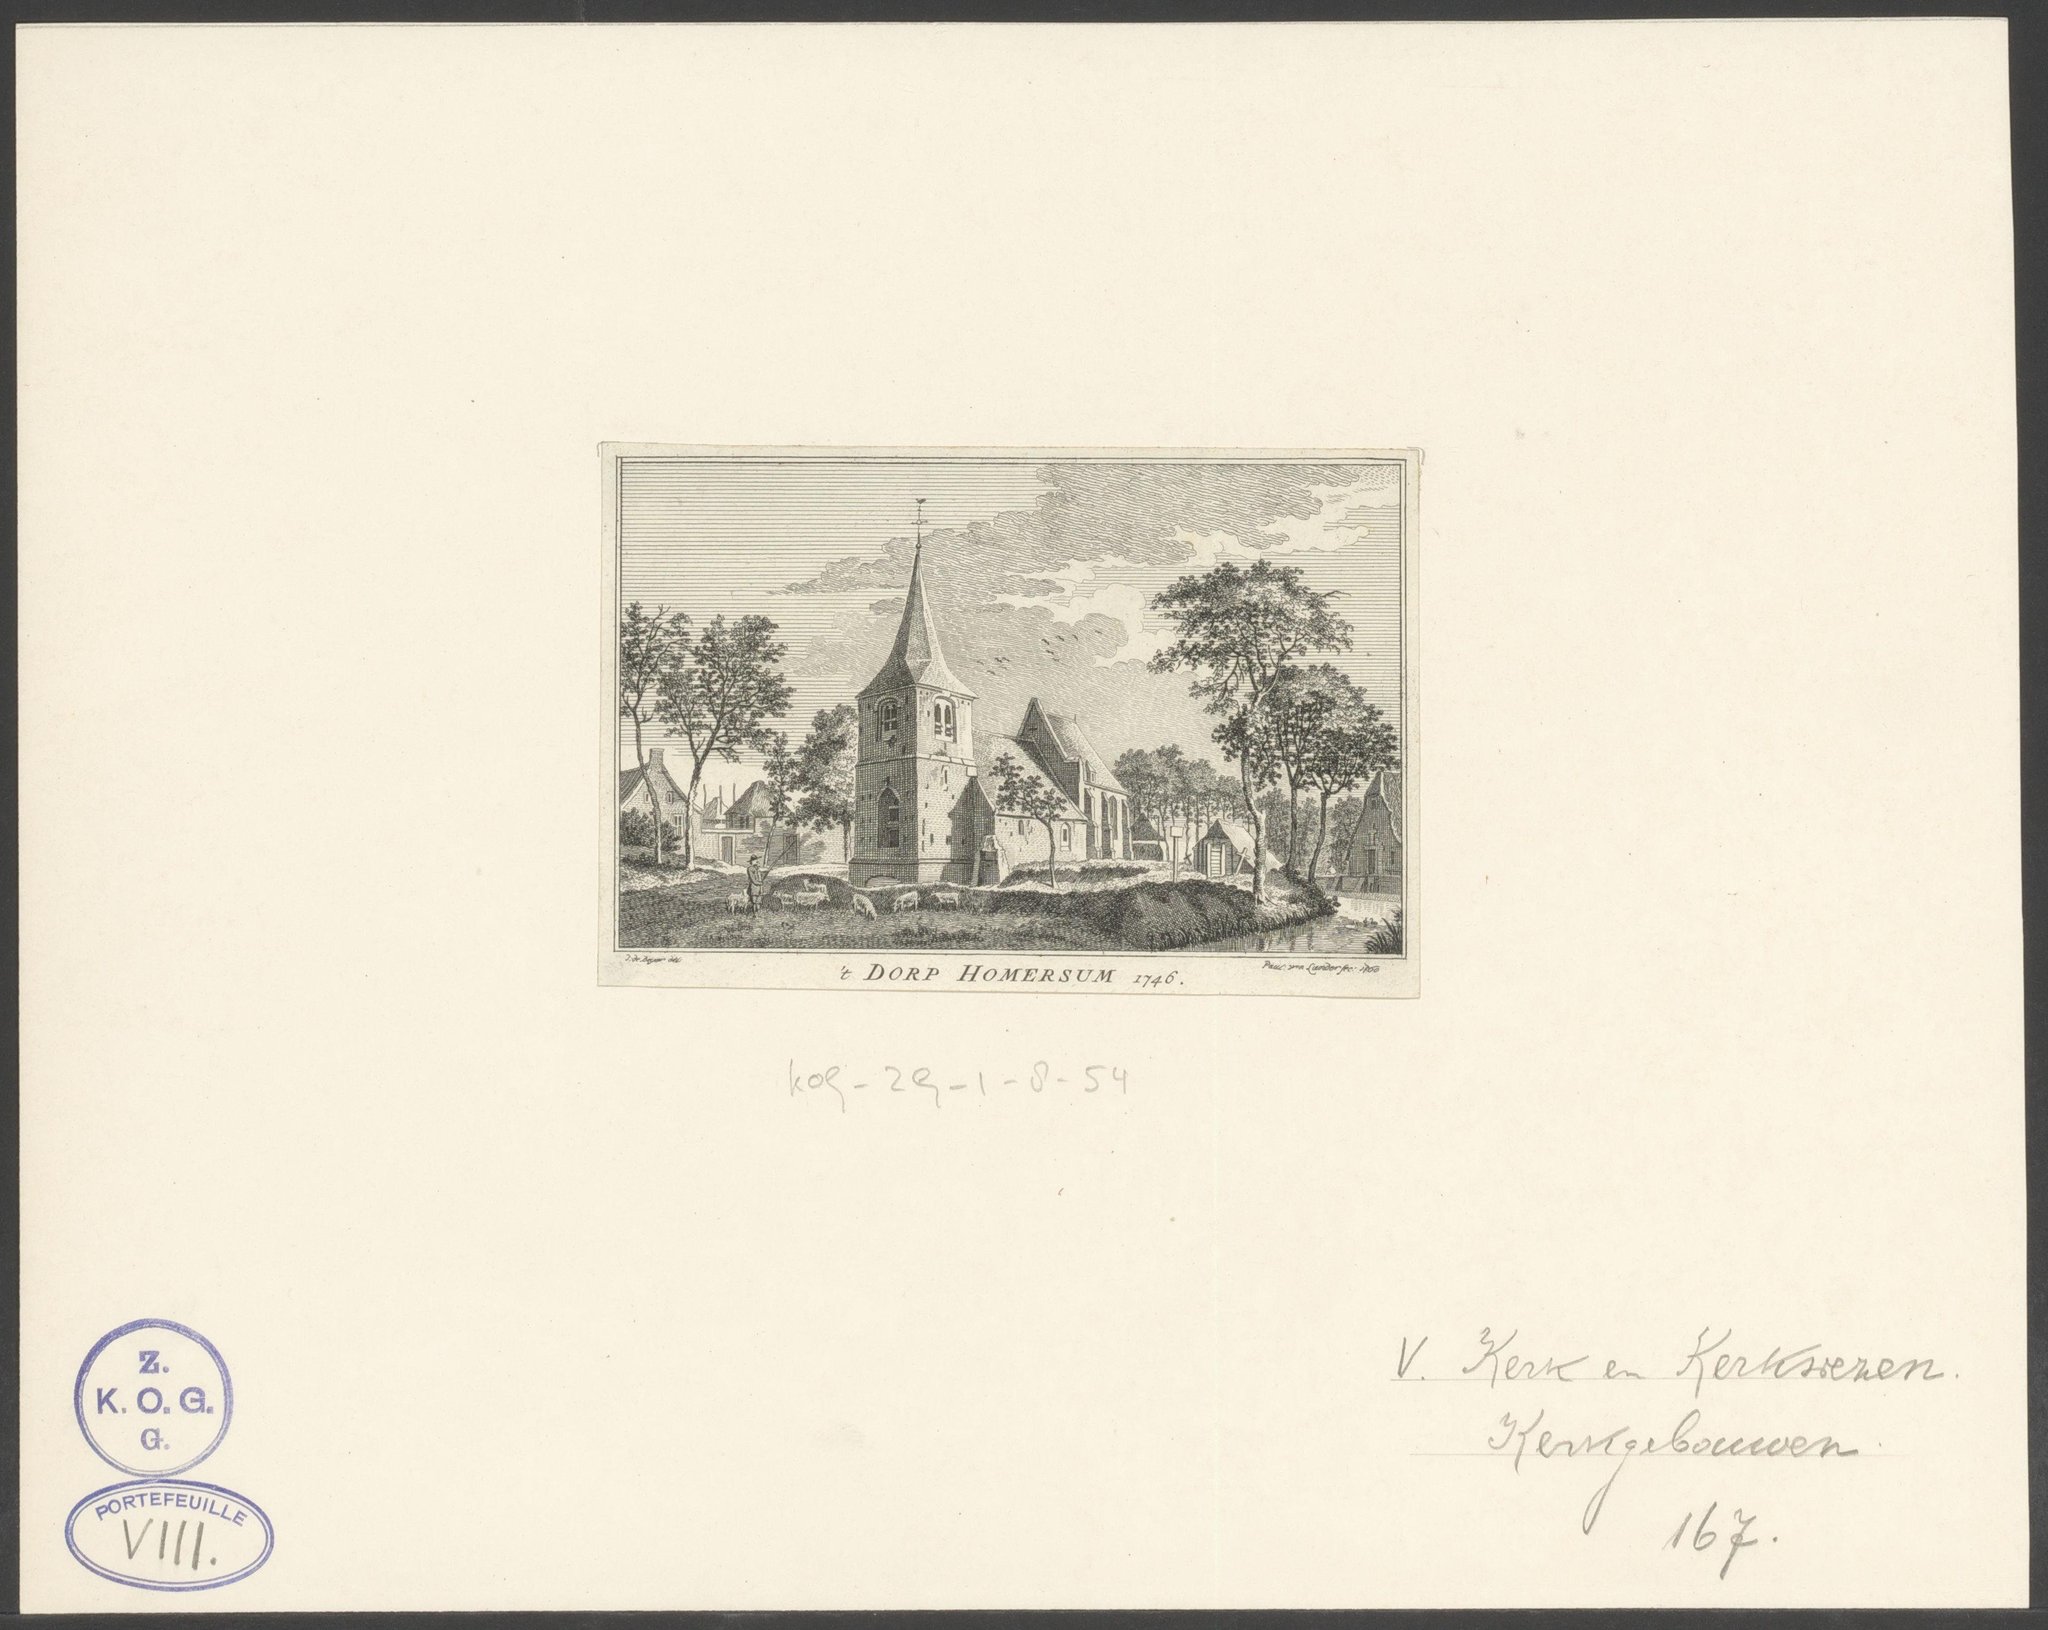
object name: print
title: 't Dorp Homersum 1746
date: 1760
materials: paper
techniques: etching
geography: netherlands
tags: village, church (exterior)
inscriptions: collector's mark, collector's mark: Lugt 1641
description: Gezicht op de kerk in het Duitse dorp Hommersum. Onderste helft van een versneden blad waar oorspronkelijk twee voorstellingen op waren gedrukt. Onderwerpsrubrieken binnen de Atlas Zeden en Gewoonten: Kerk en kerkwezen & Armwezen en liefdadige instellingen; Kerkgebouwen elders. F-L.